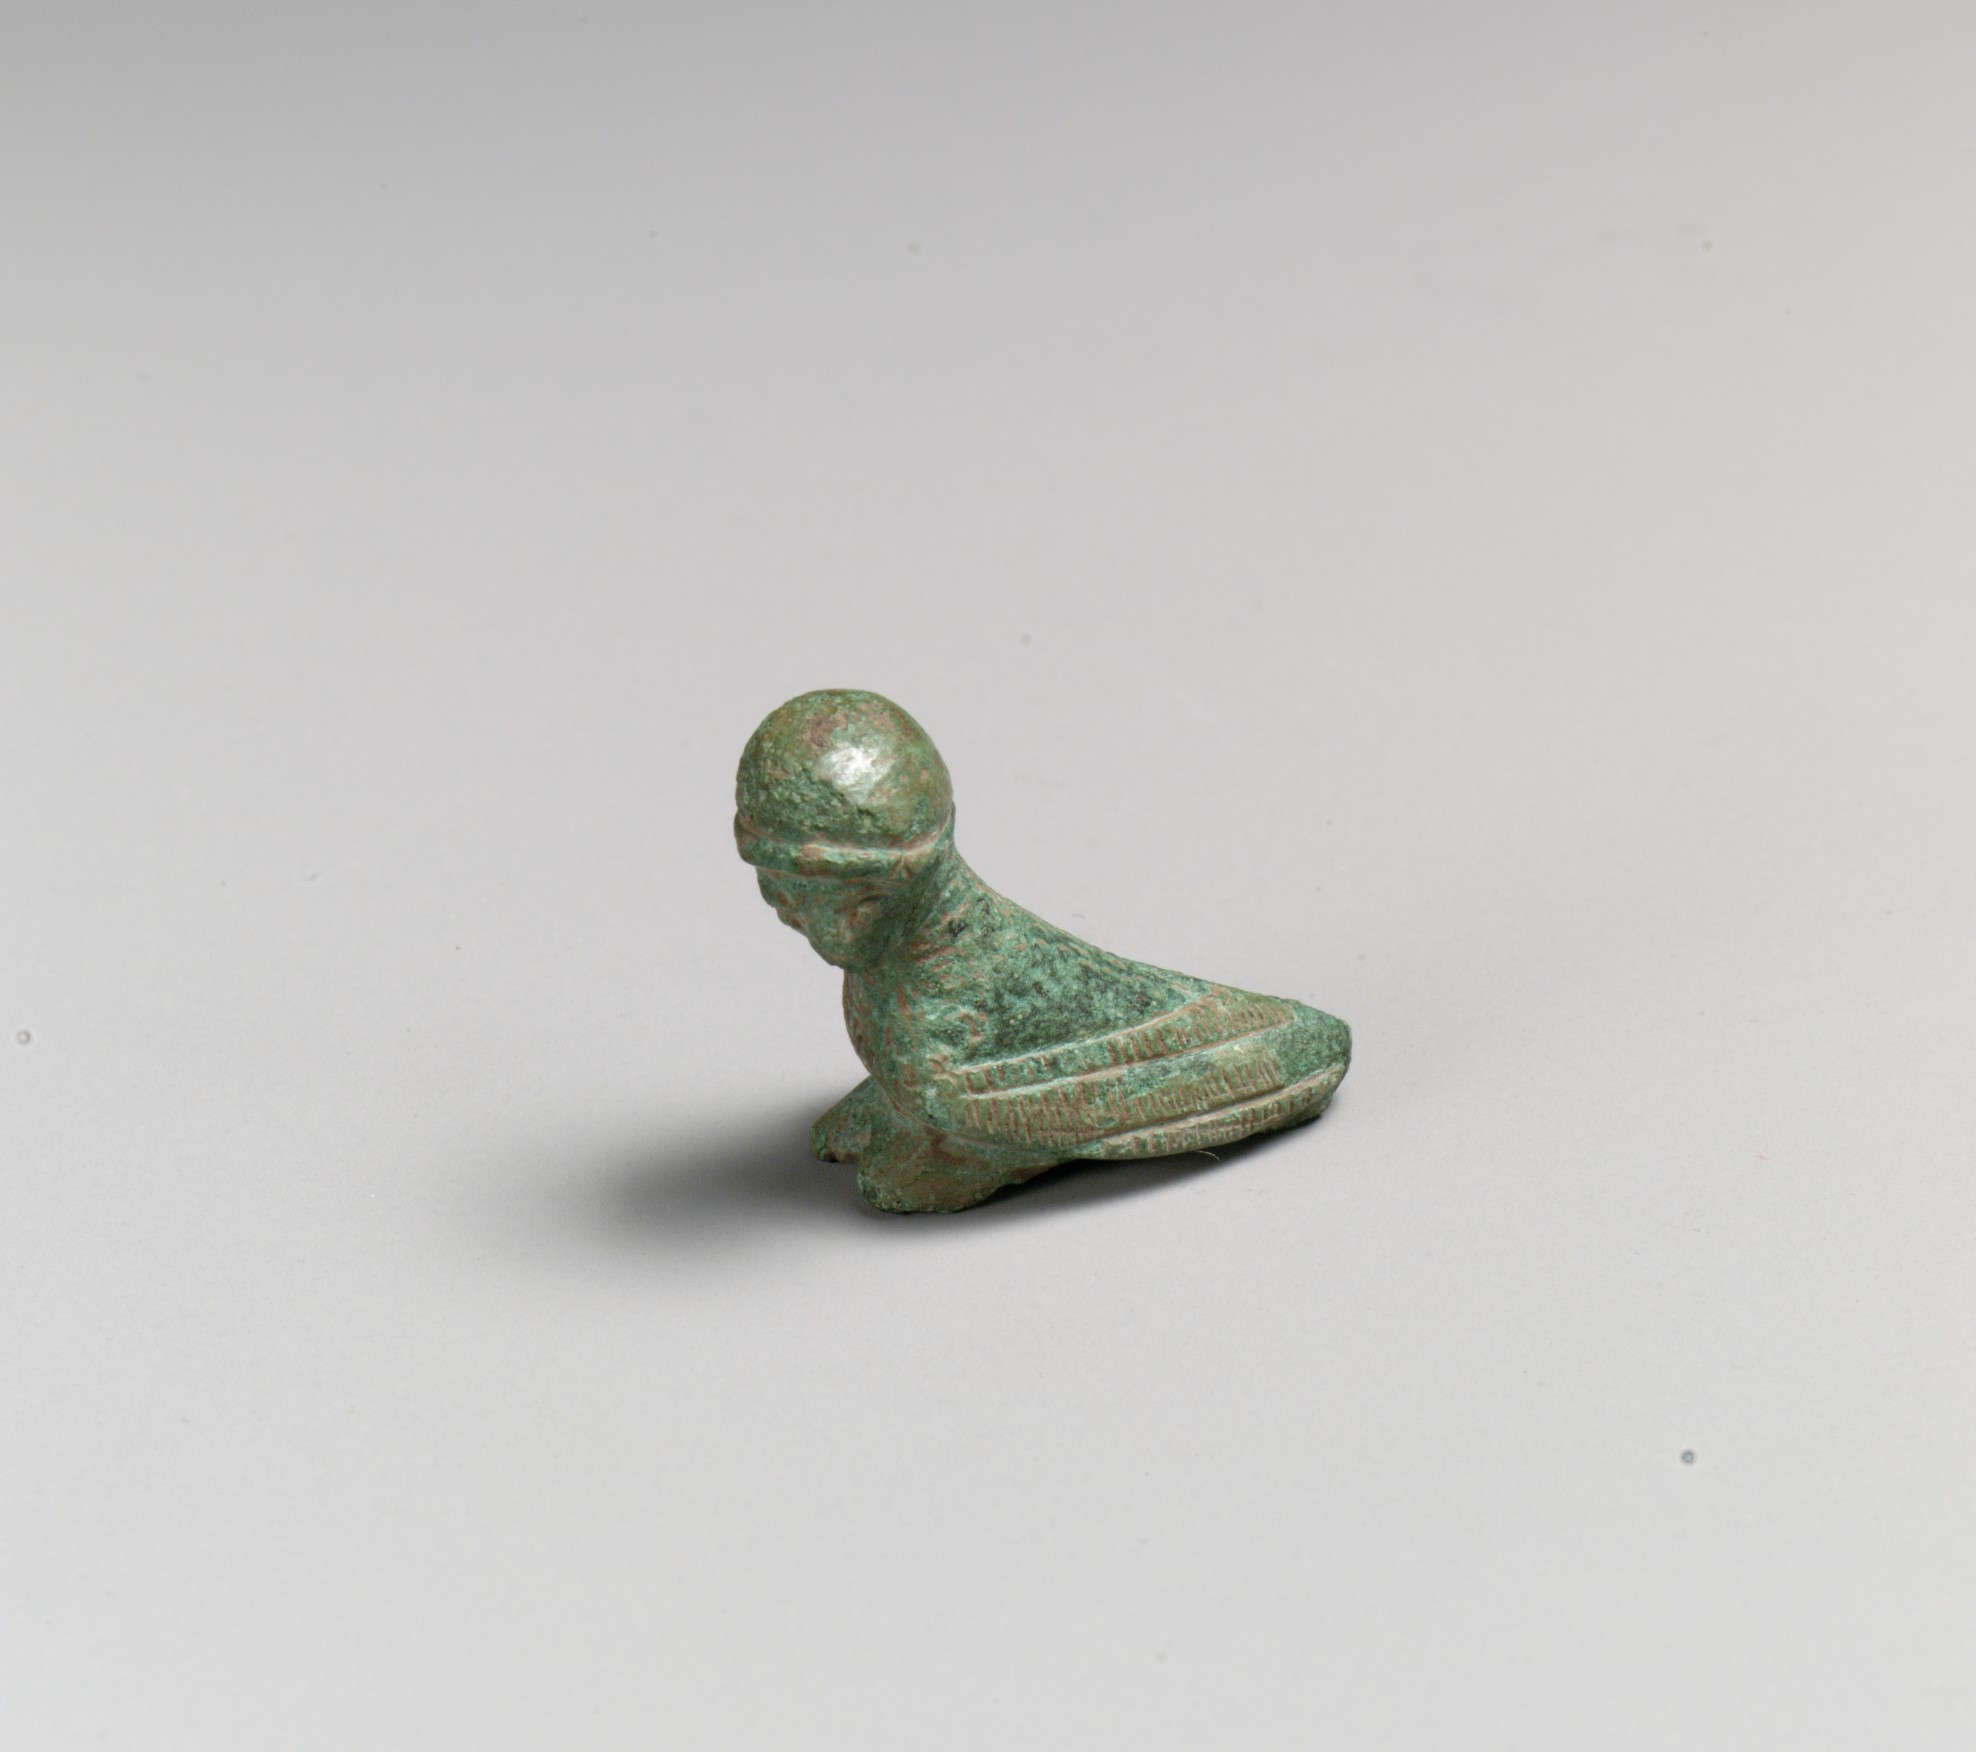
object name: statuette of a siren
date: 7000 BCE-330 CE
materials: bronze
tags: sirens